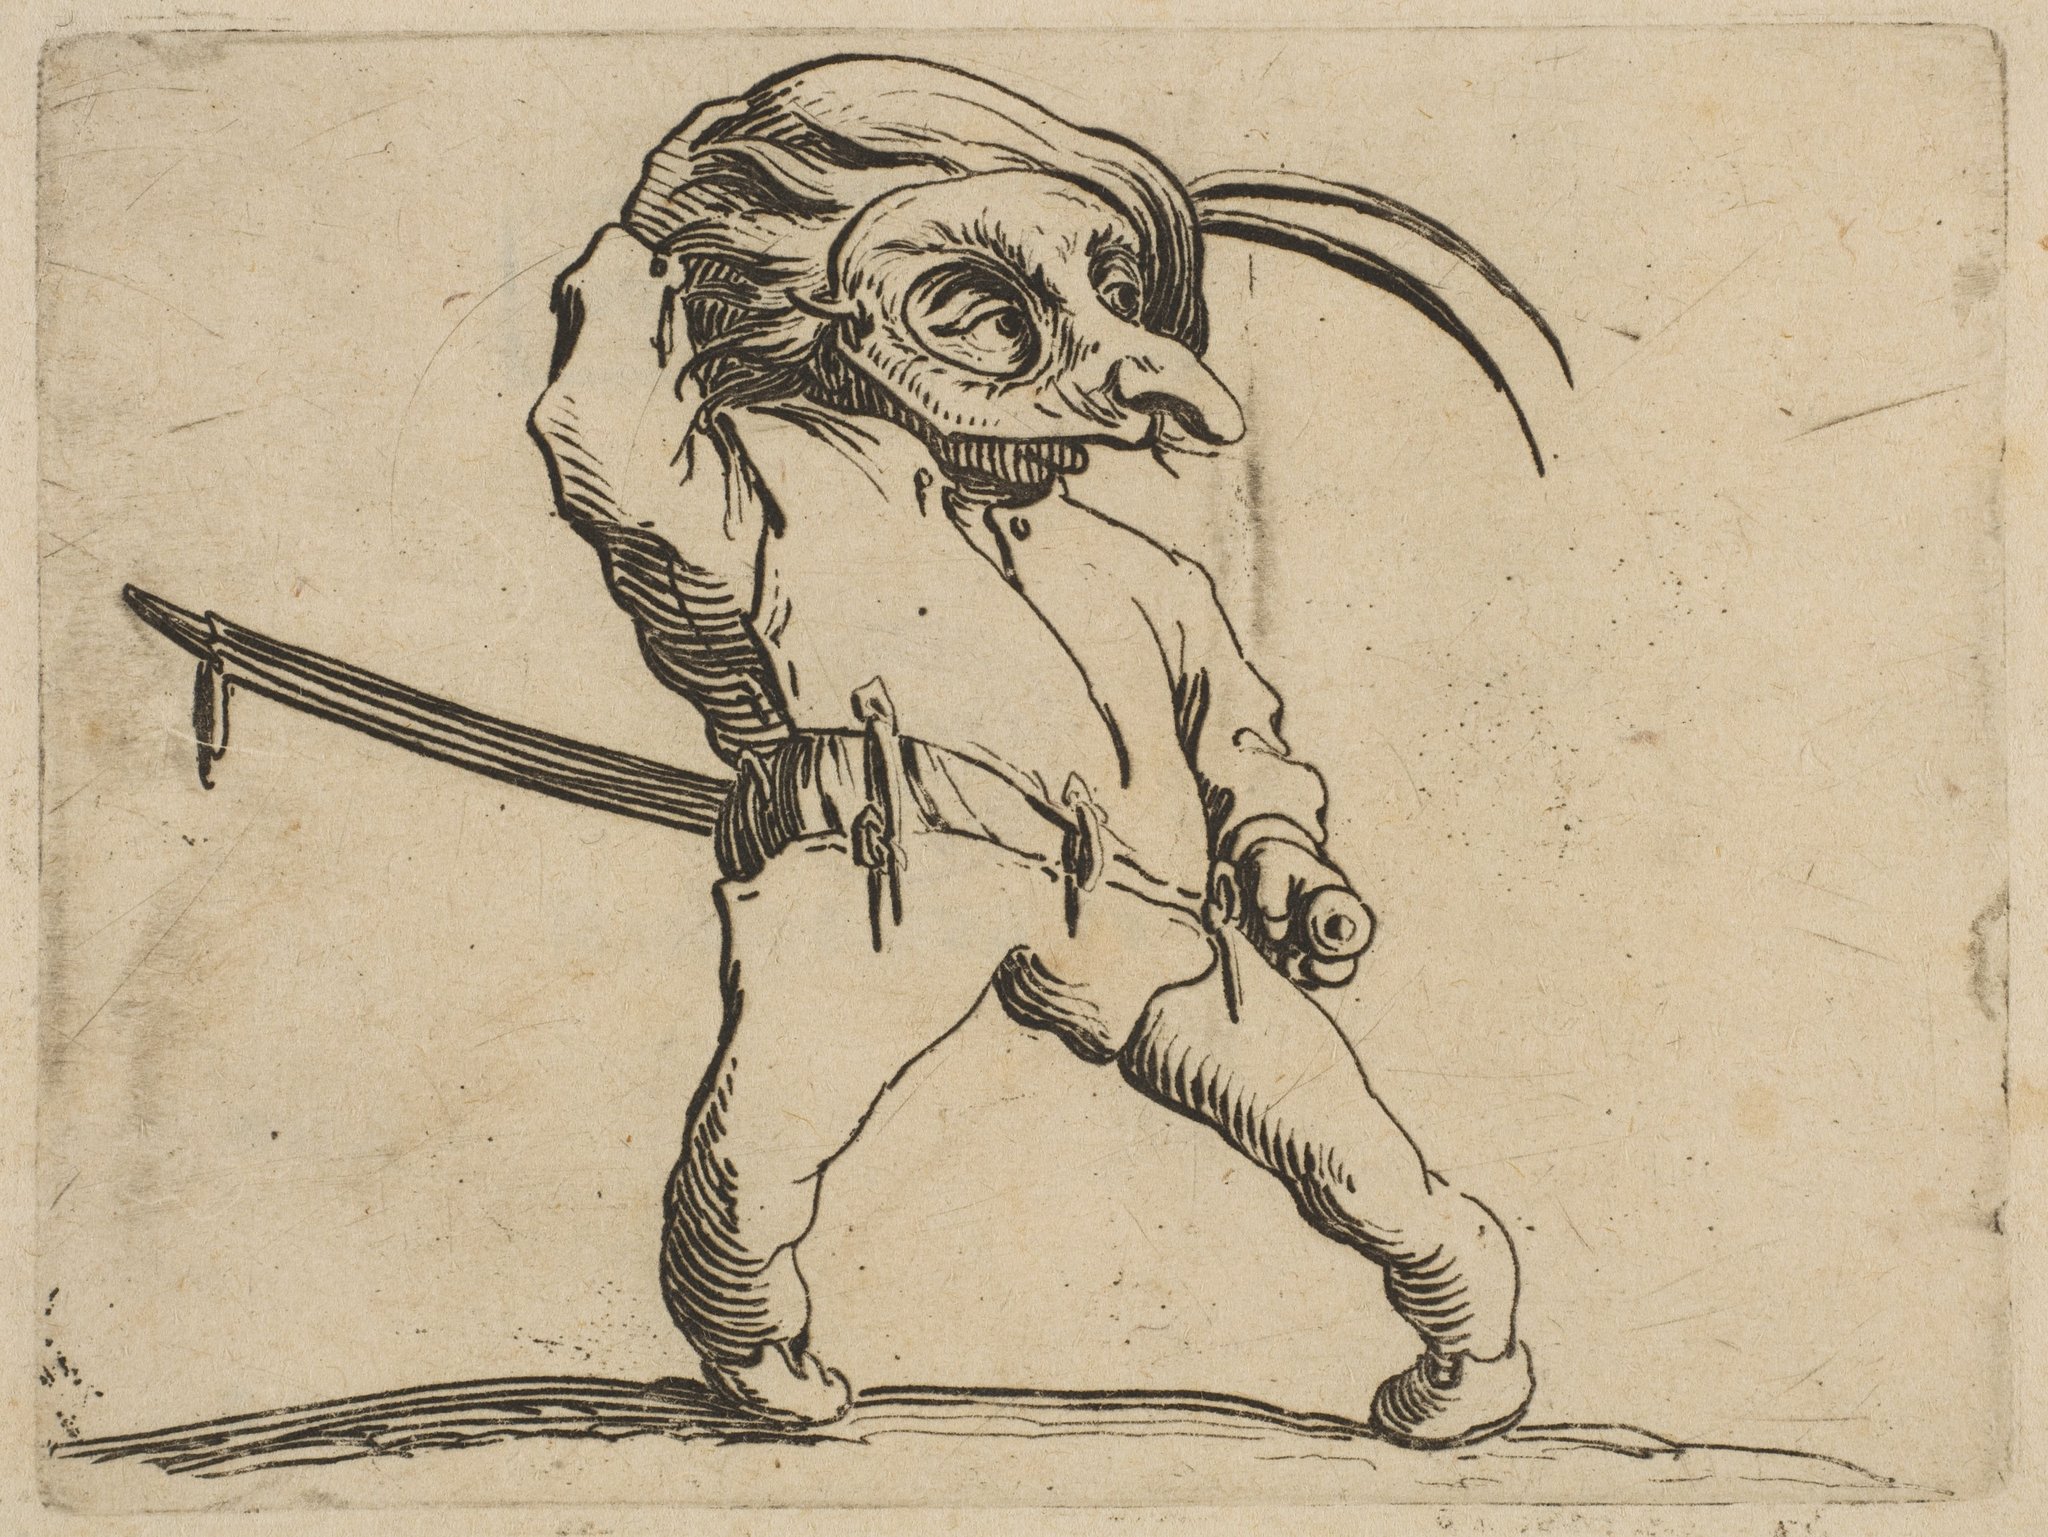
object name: print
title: L'Homme Masqué aux Jambes Torses (The Masked Man with Crooked Legs), from "Varie Figure Gobbi, suite appelée aussi Les Bossus, Les Pygmées, Les Nains Grotesques" (Various Hunchbacked Figures, The Hunchbacks, The Pygmes, The Grotesque Dwarfs)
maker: jacques callot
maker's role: artist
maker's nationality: french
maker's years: 1592-1635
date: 1616-1622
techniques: engraving, etching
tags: masks,men